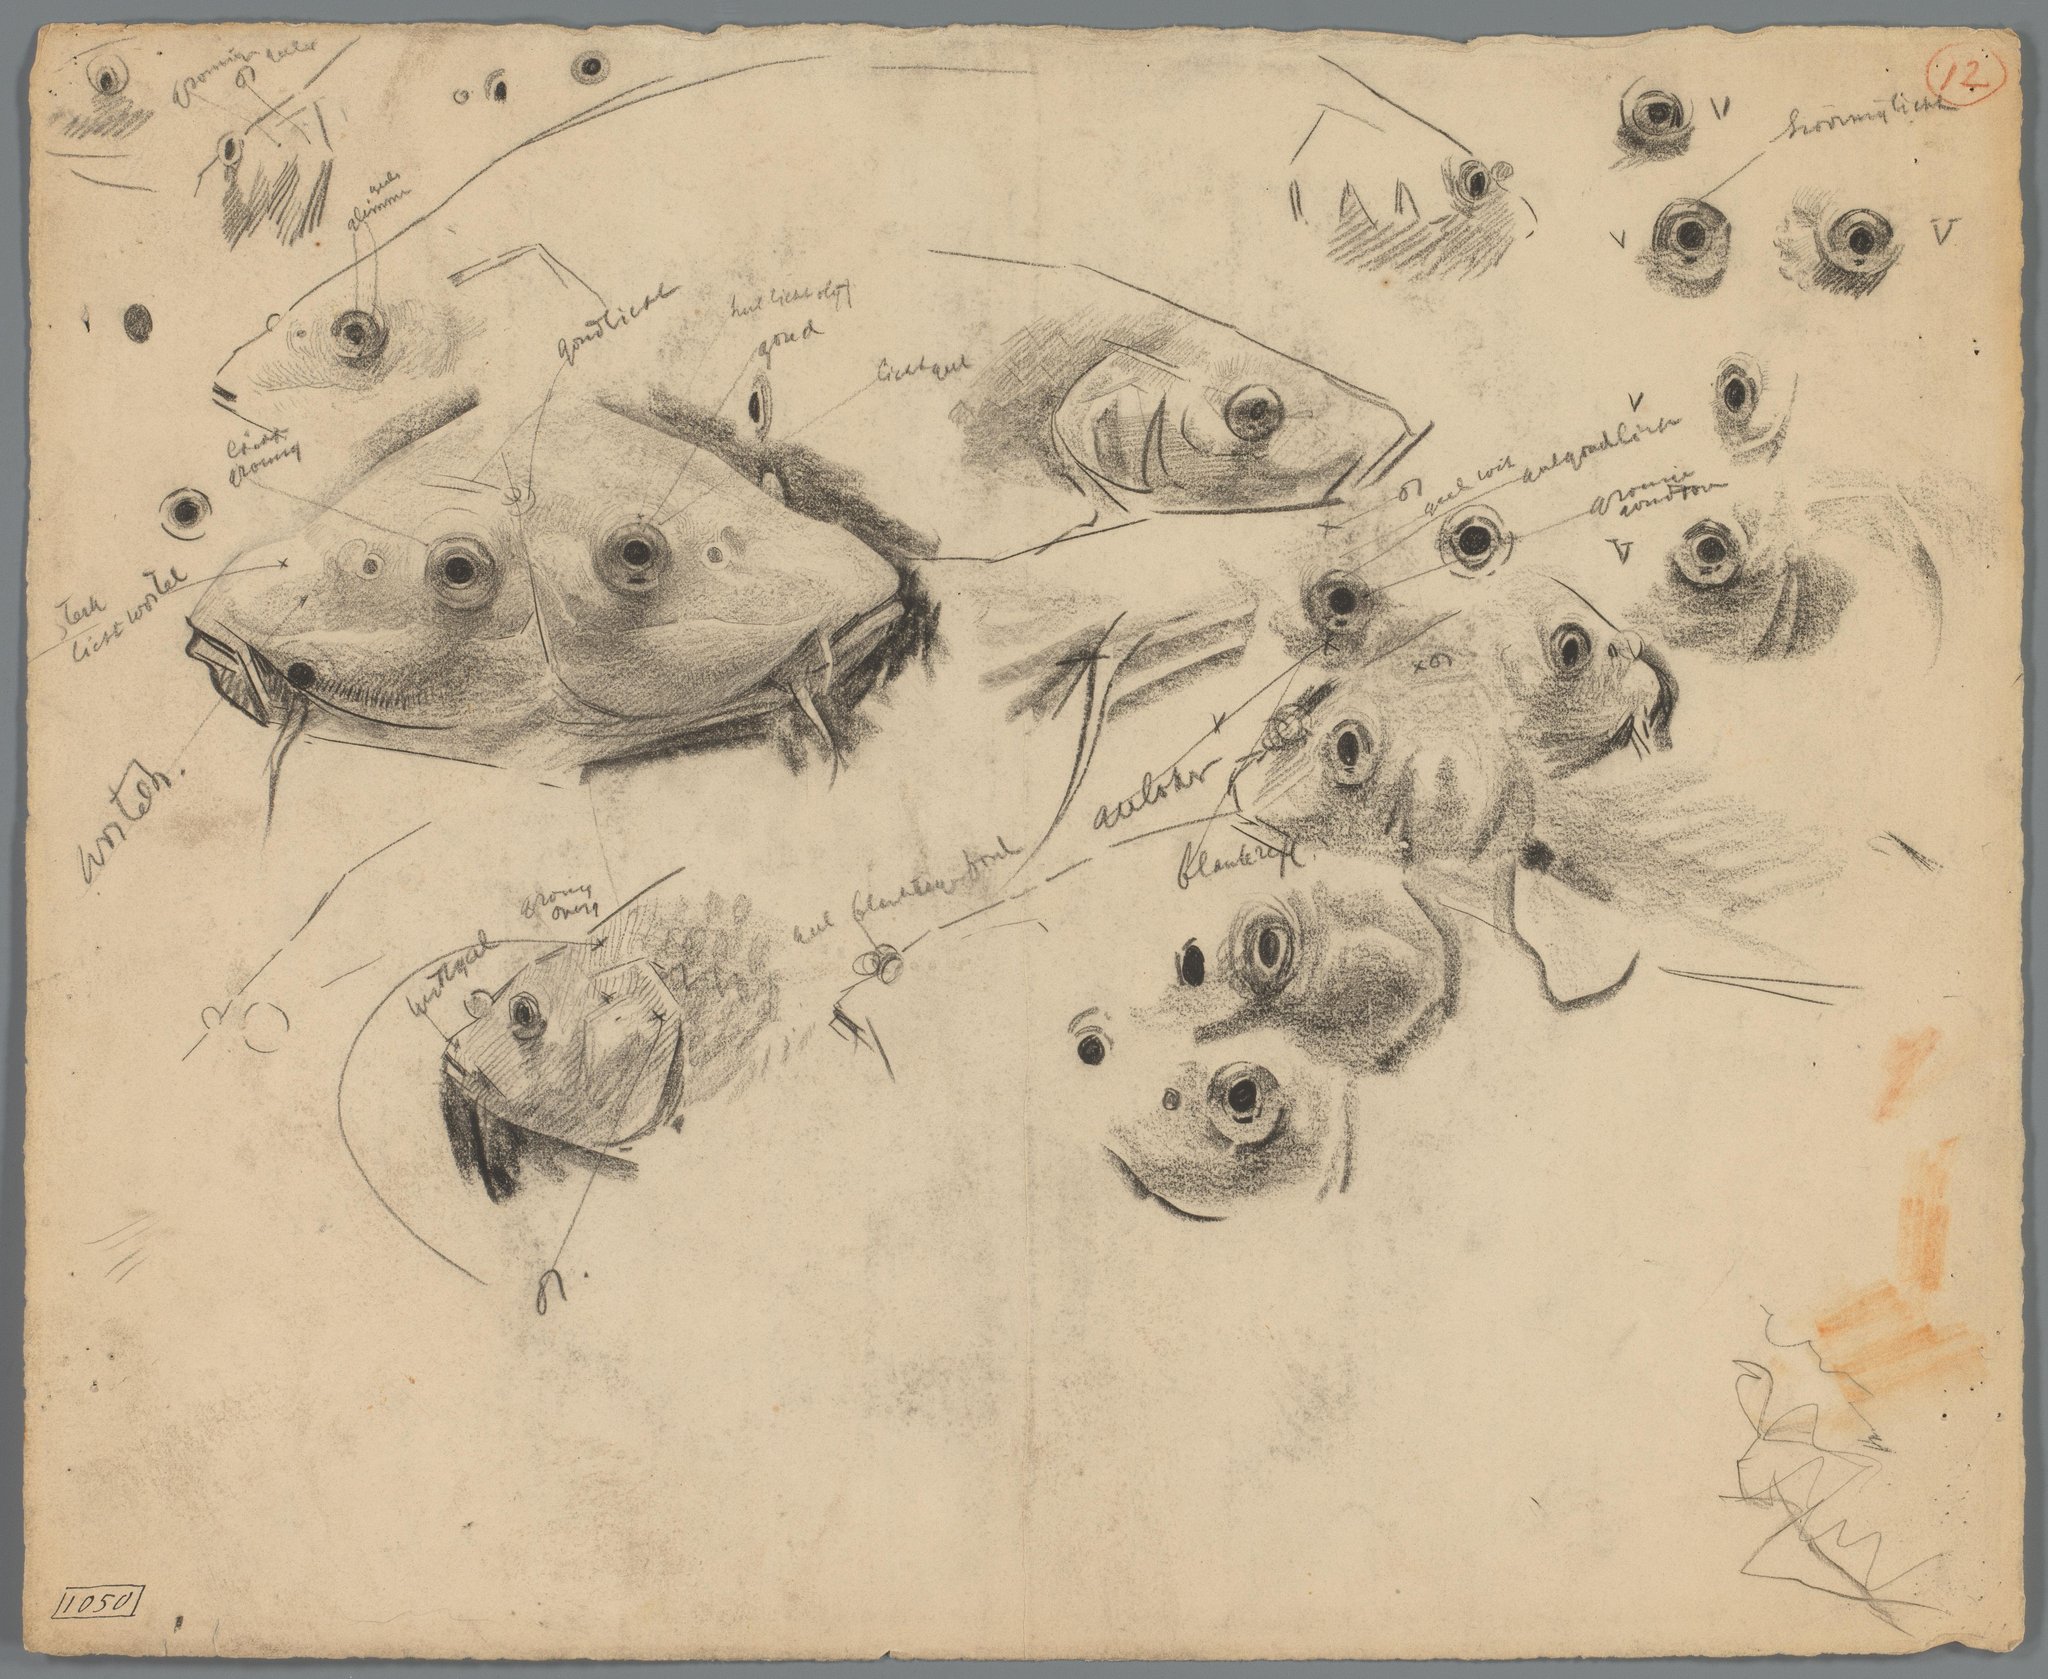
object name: drawing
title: Studies van de koppen en ogen van karpers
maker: gerrit willem dijsselhof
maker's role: designer, draughtsman, print maker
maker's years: 1866-1924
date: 1876-1924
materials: chalk, paper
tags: bony fishes: carp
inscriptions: number: ‘1050’